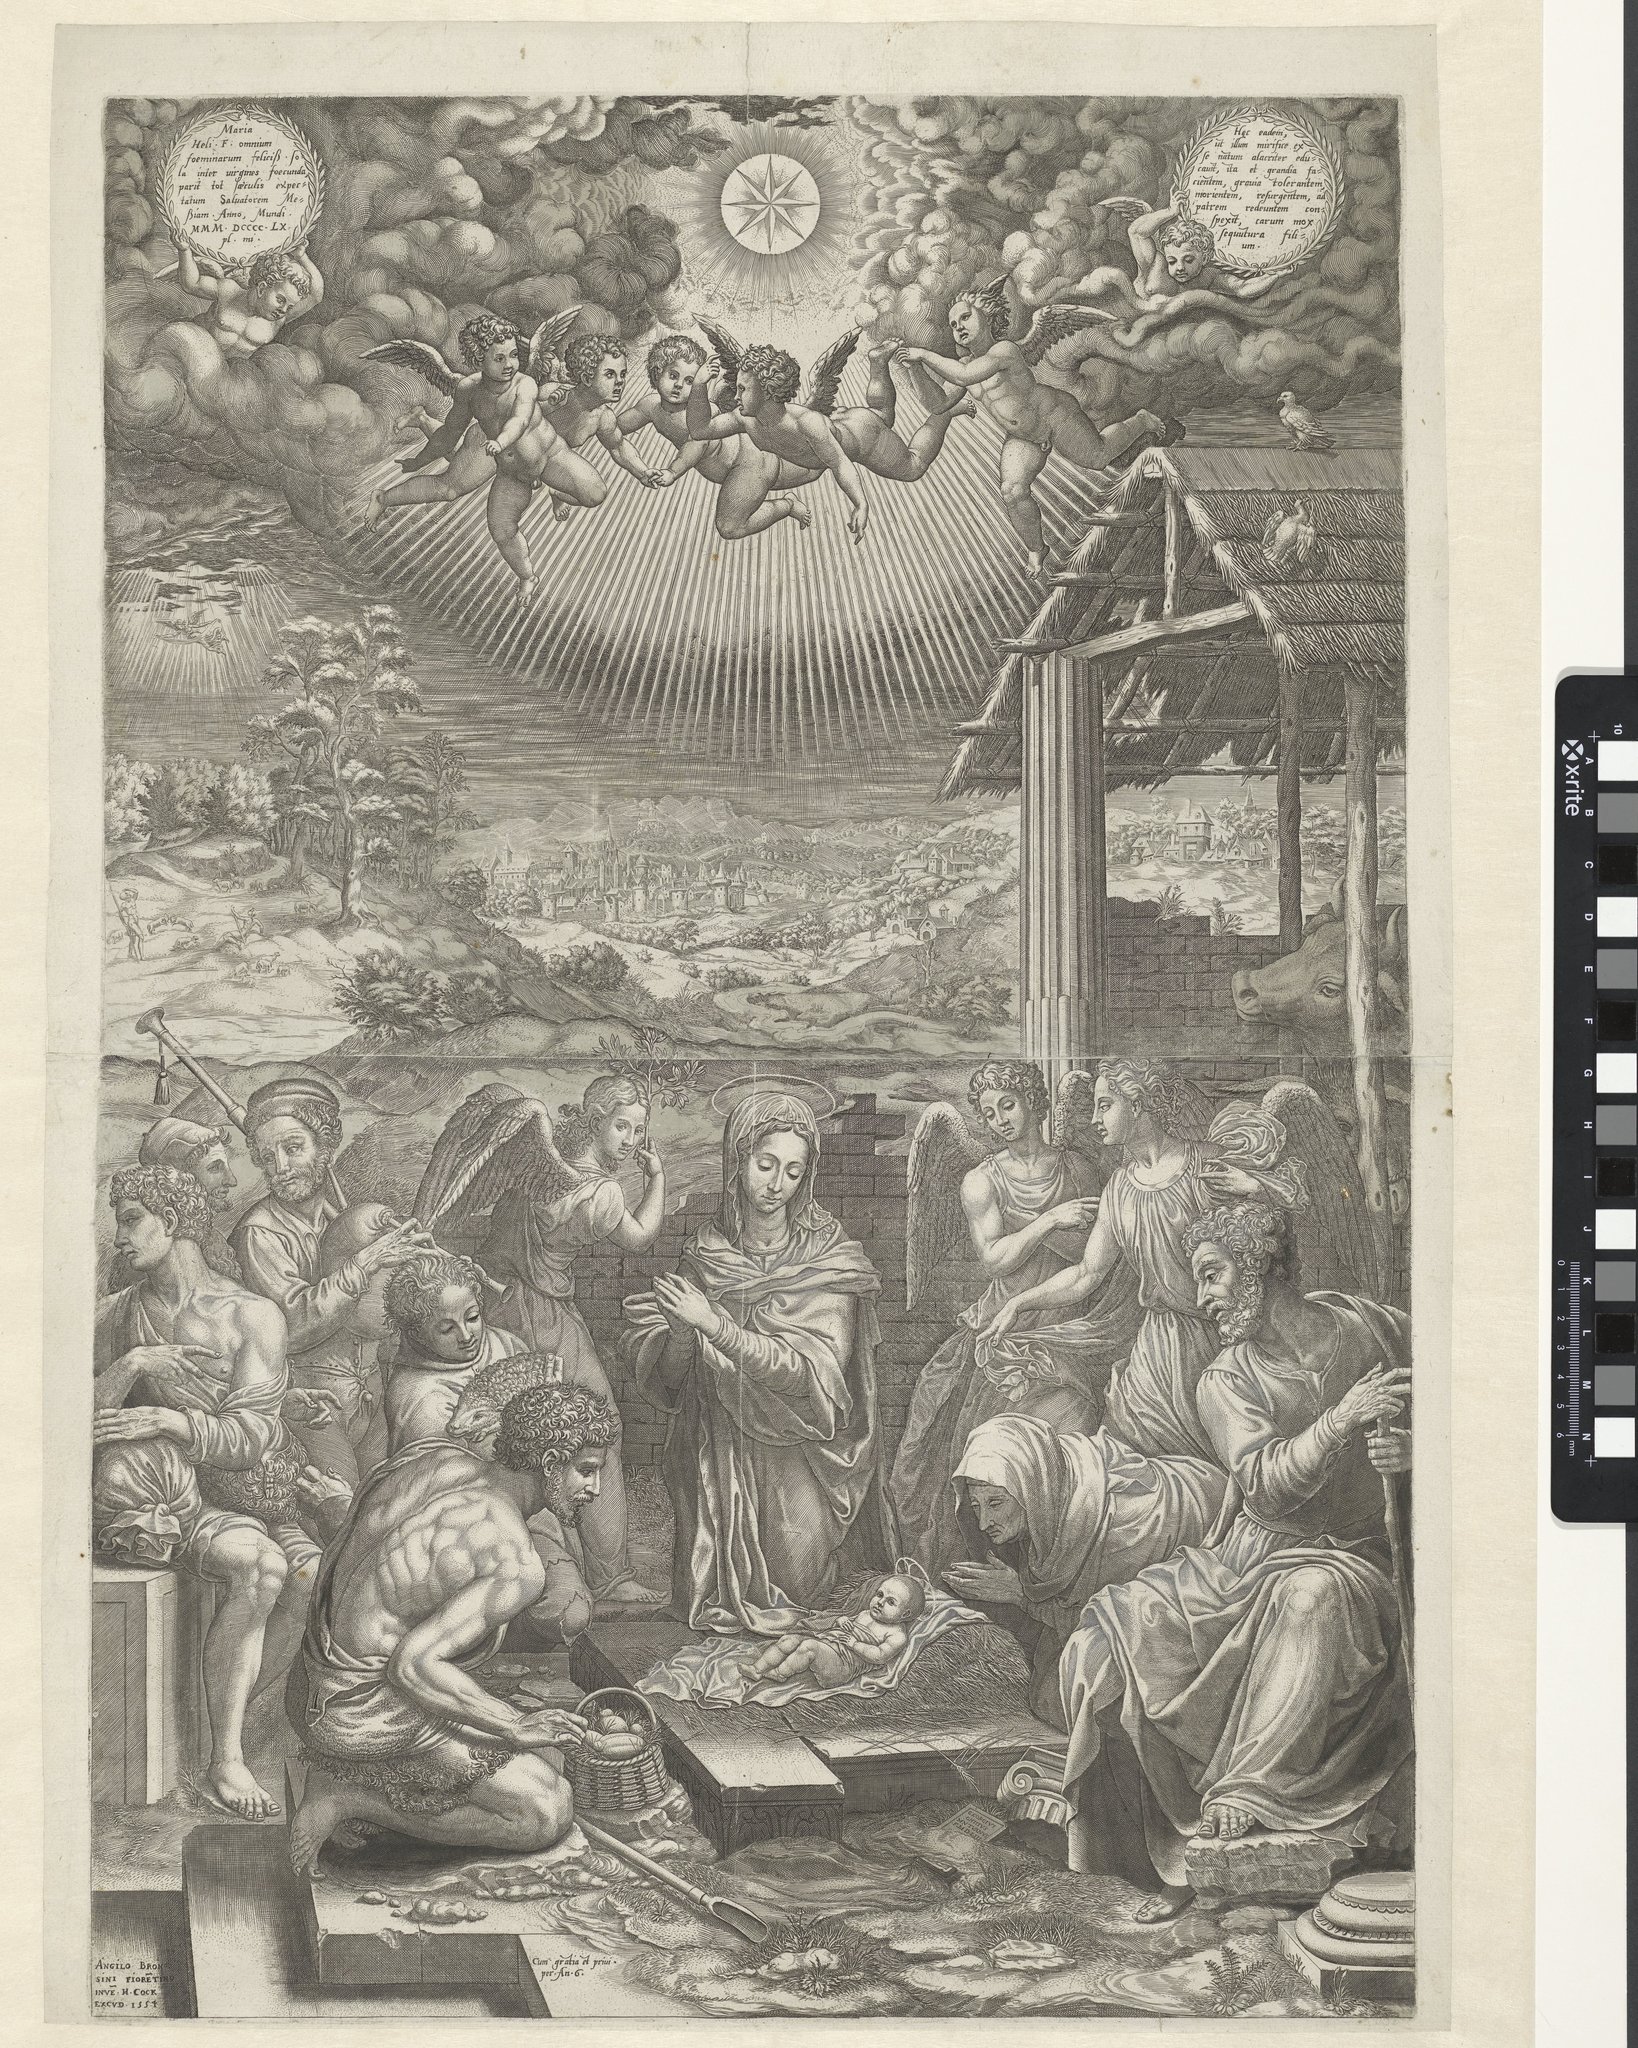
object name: print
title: Geboorte van Christus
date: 1554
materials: paper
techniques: engraving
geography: italy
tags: mary, joseph and the new-born christ (nativity)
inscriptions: collector's mark: Lugt 240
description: Het Christuskind ligt in het stro voor een stal. Rondom zitten Maria, Jozef, engelen en herders. Boven zweven putti tussen de wolken. Op de achtergrond een weids landschap.